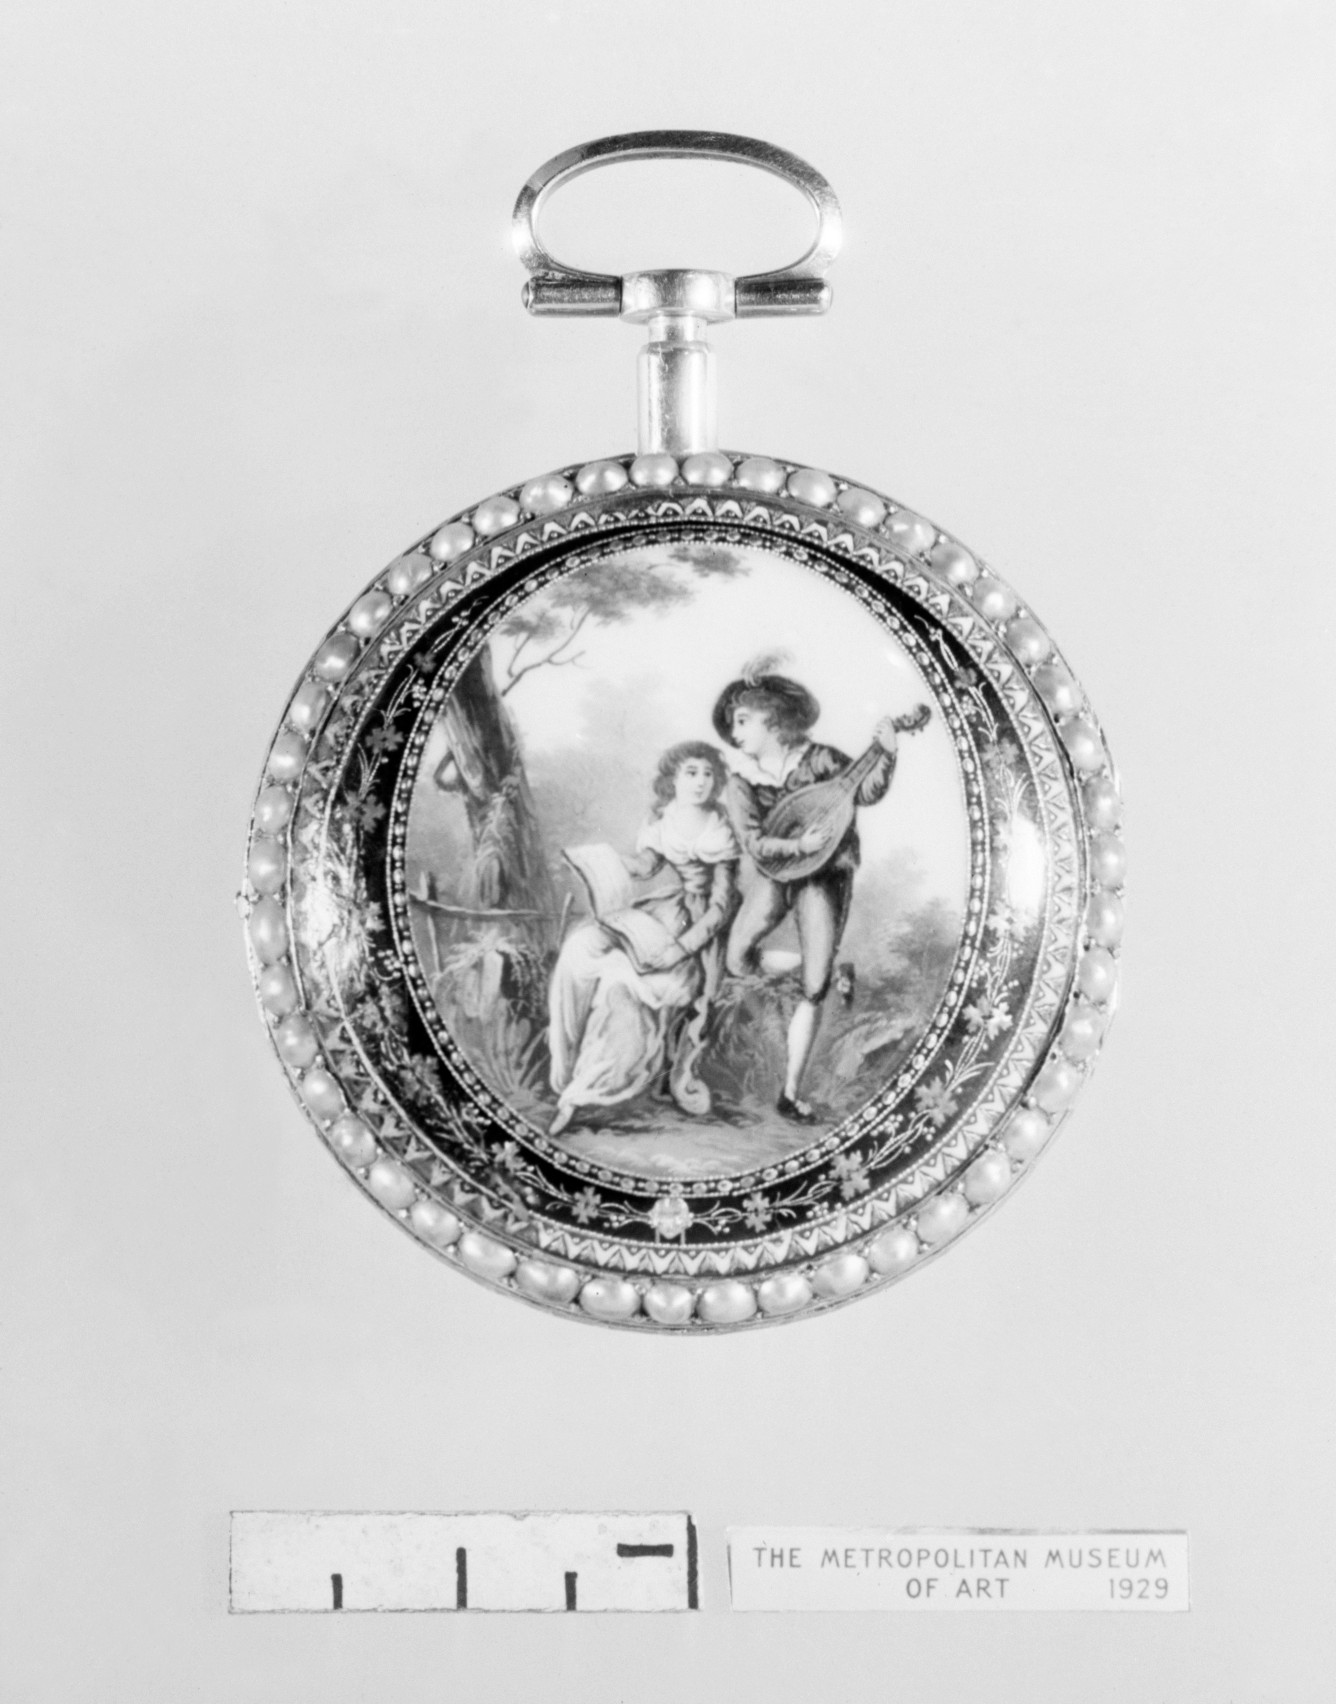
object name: repeating watch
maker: firm of meuron et companie, geneva and paris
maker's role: maker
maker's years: 1785-1810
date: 1767-1800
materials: enamel, gold, pearl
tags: boys,girls,lutes